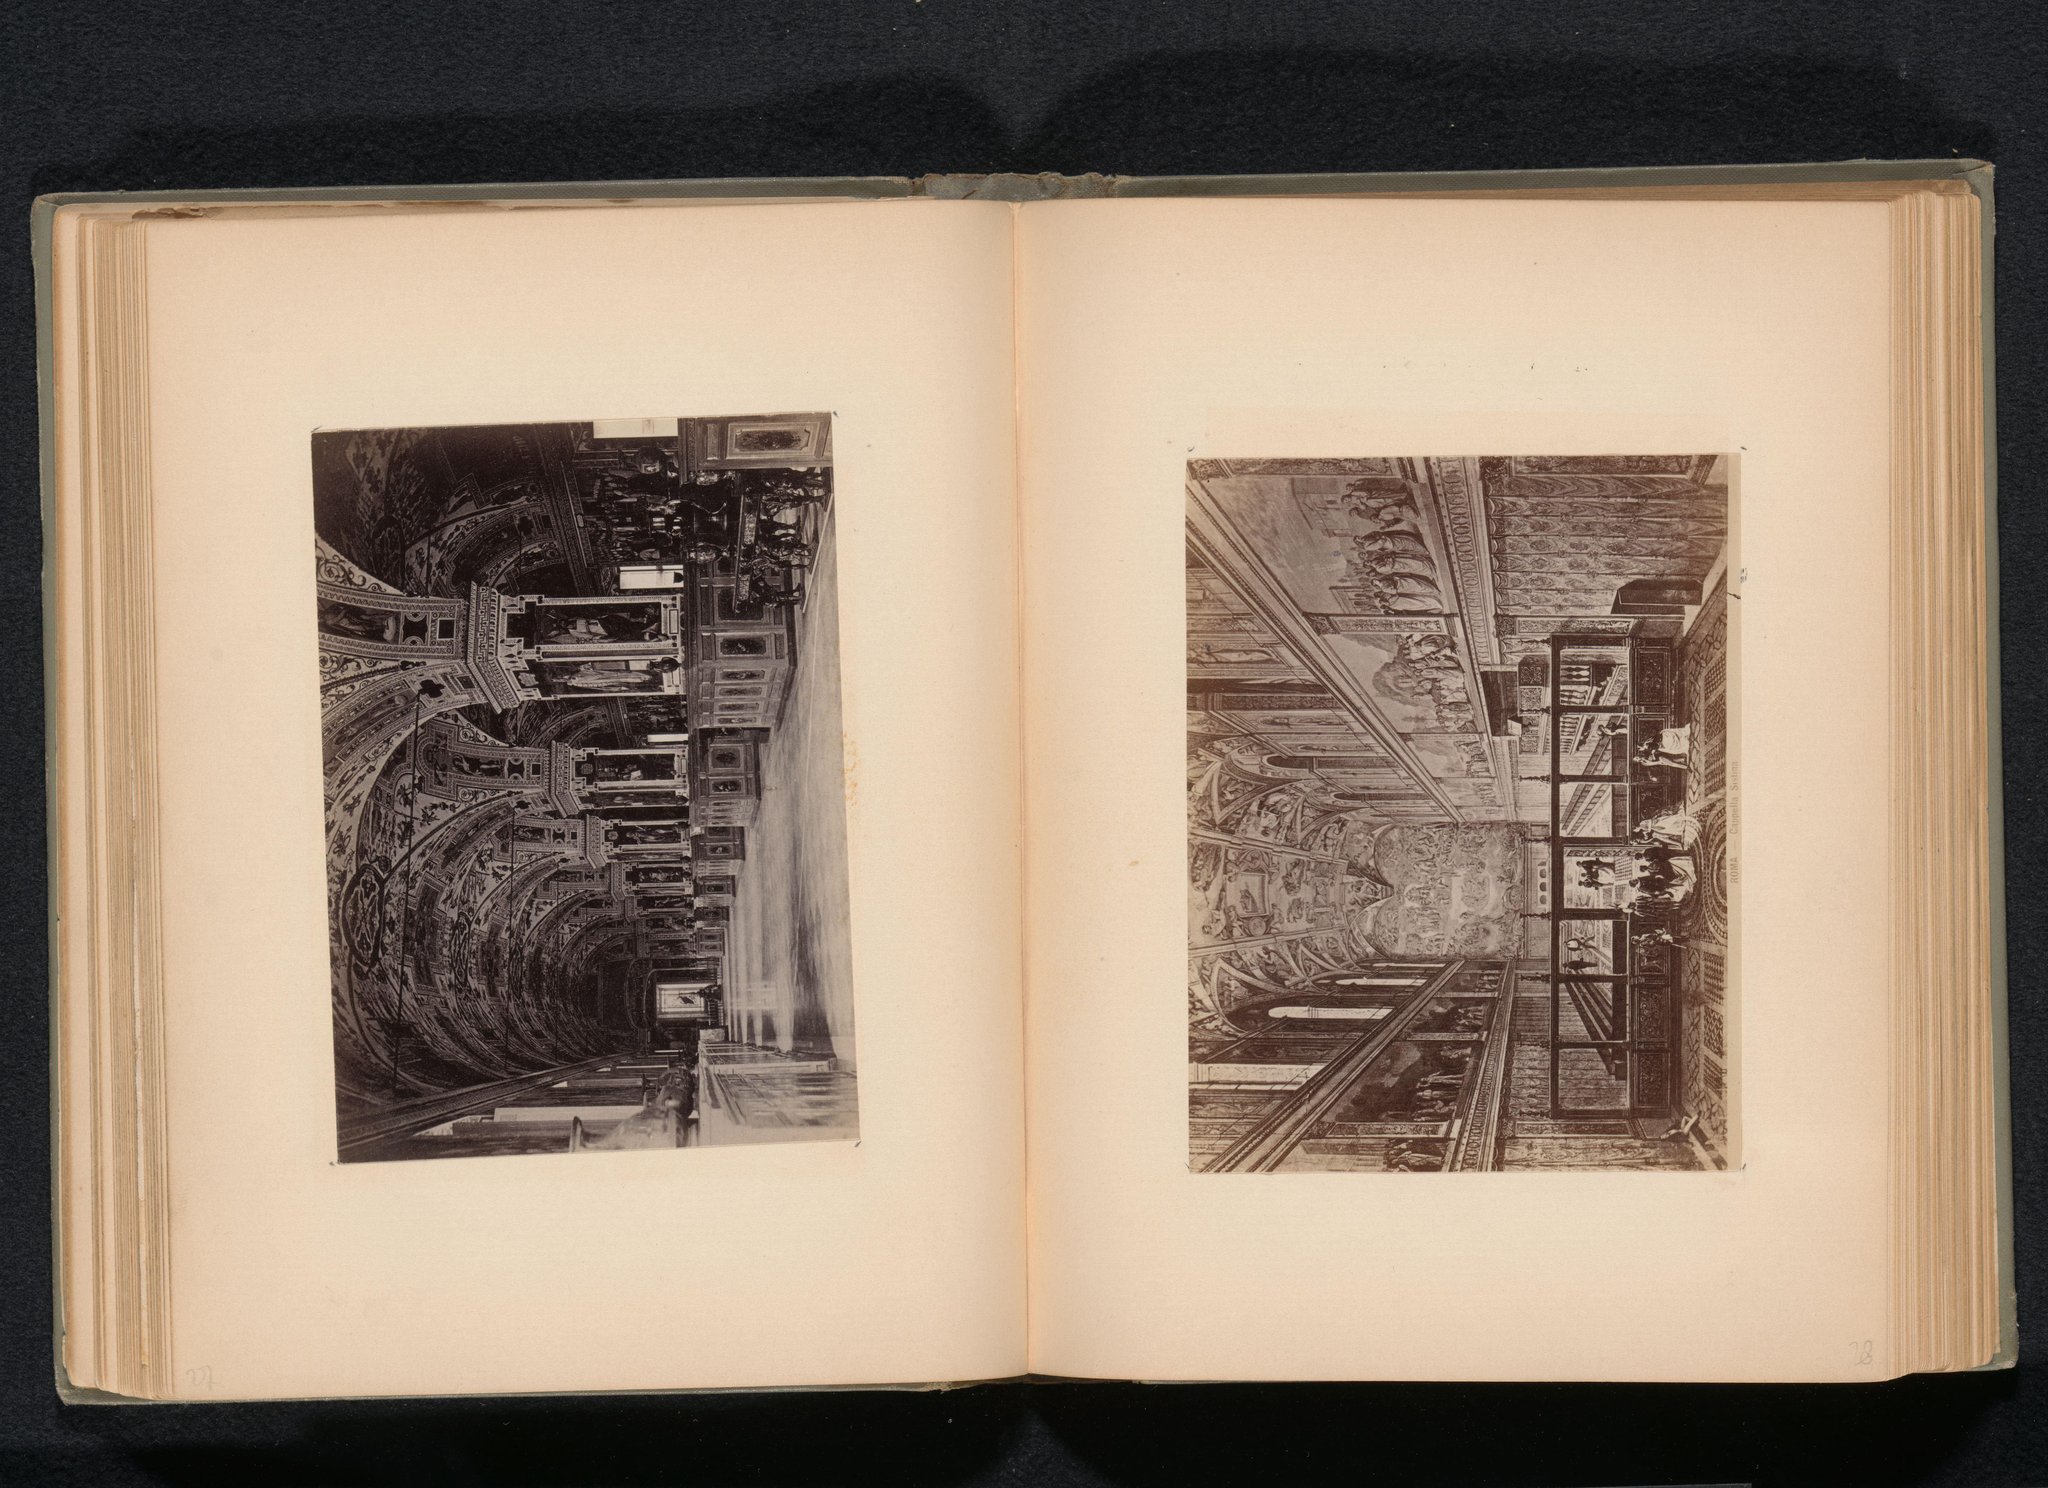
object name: photograph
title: Fotoreproductie van een tekening, voorstellende de Sixtijnse Kapel in het Apostolisch Paleis te Vaticaanstad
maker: Anonymous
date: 1882-1887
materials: photographic support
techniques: albumen print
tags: parts of church interior: chapel